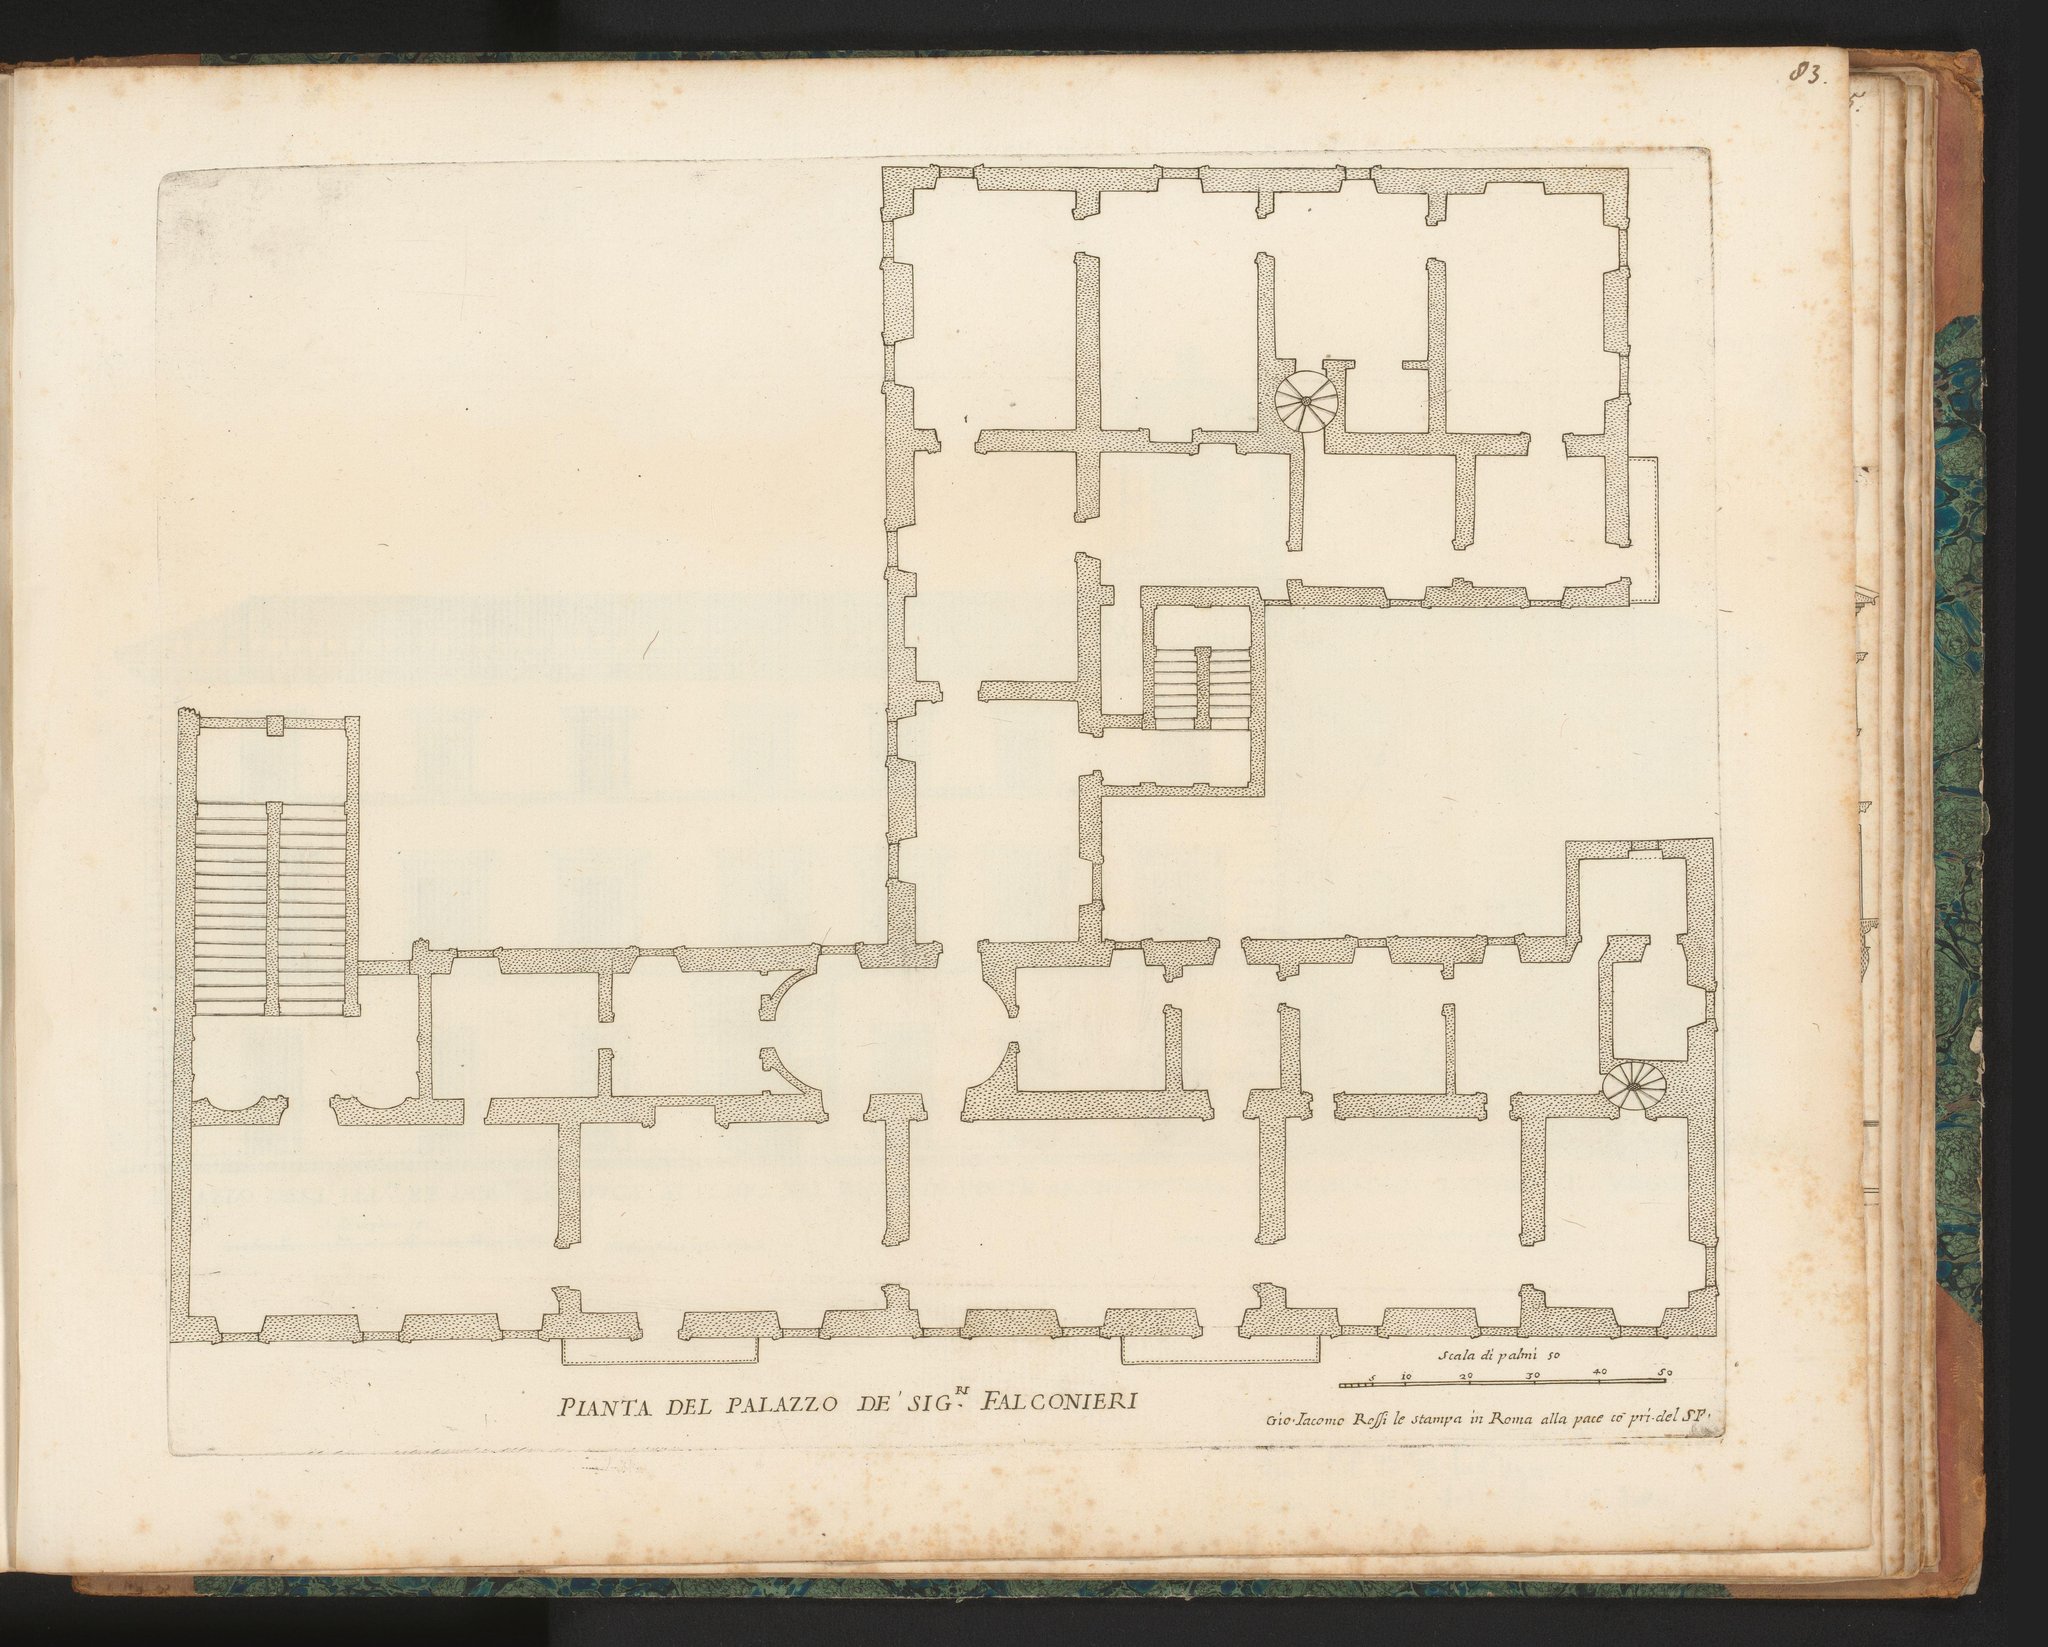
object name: album leaf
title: Palazzi di Roma dei più celebri architett (...)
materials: paper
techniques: etching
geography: italy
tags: palace, plan ~ architecture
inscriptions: number: ‘83’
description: Deze prent maakt deel uit van de reeks getiteld: Palazzi di Roma. Deze reeks bestaat uit twee boeken. Boek één getiteld: Palazzi di Roma dei più celebri architetti..., bestaat uit 44 prenten die worden toegeschreven aan Giovanni Battista Falda (naam staat enkel op prent 27) en uitgegeven door Giovanni Giacomo de'Rossi. Deze 44 prenten zijn bekend in twee staten (met en zonder nummer). Boek twee getiteld: Nuovi disegni dell'architetture... libro secondo, bevat 66 prenten door Giovanni Battista Falda en Simone Felice. Deze 66 prenten zijn bekend in twee staten (met en zonder nummer).